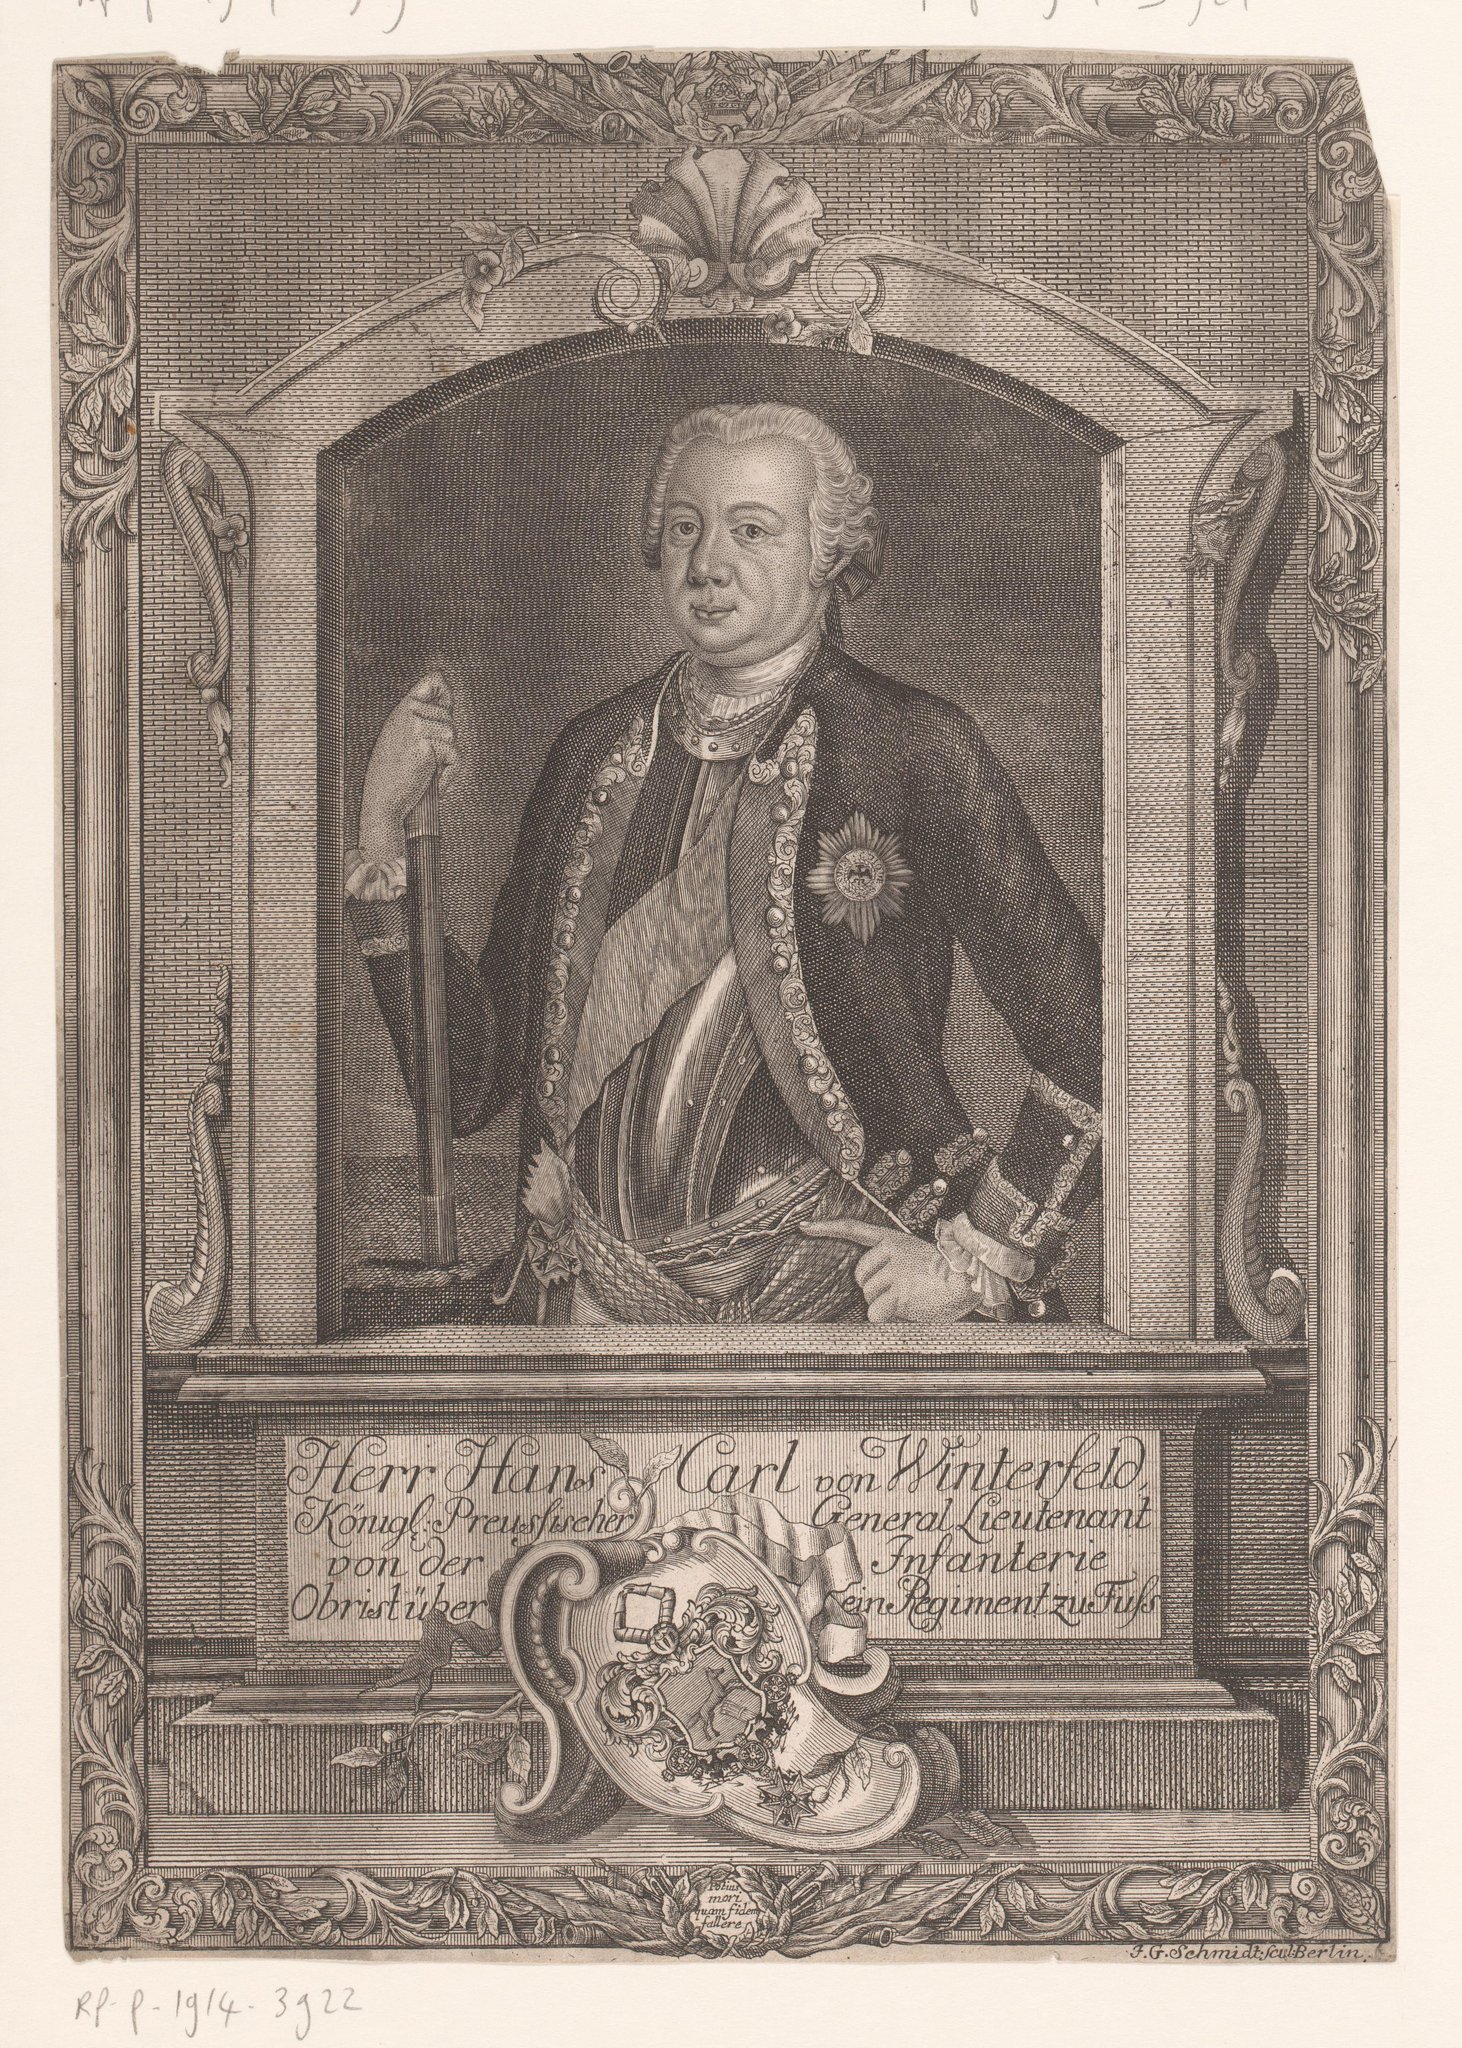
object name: print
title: Portret van Hans Carl von Winterfeld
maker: johann georg schmidt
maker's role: print maker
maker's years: 1694-1767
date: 1717-1765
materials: paper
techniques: engraving, etching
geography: berlin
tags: historical persons, armorial bearing, heraldry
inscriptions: collector's mark: Lugt 2228